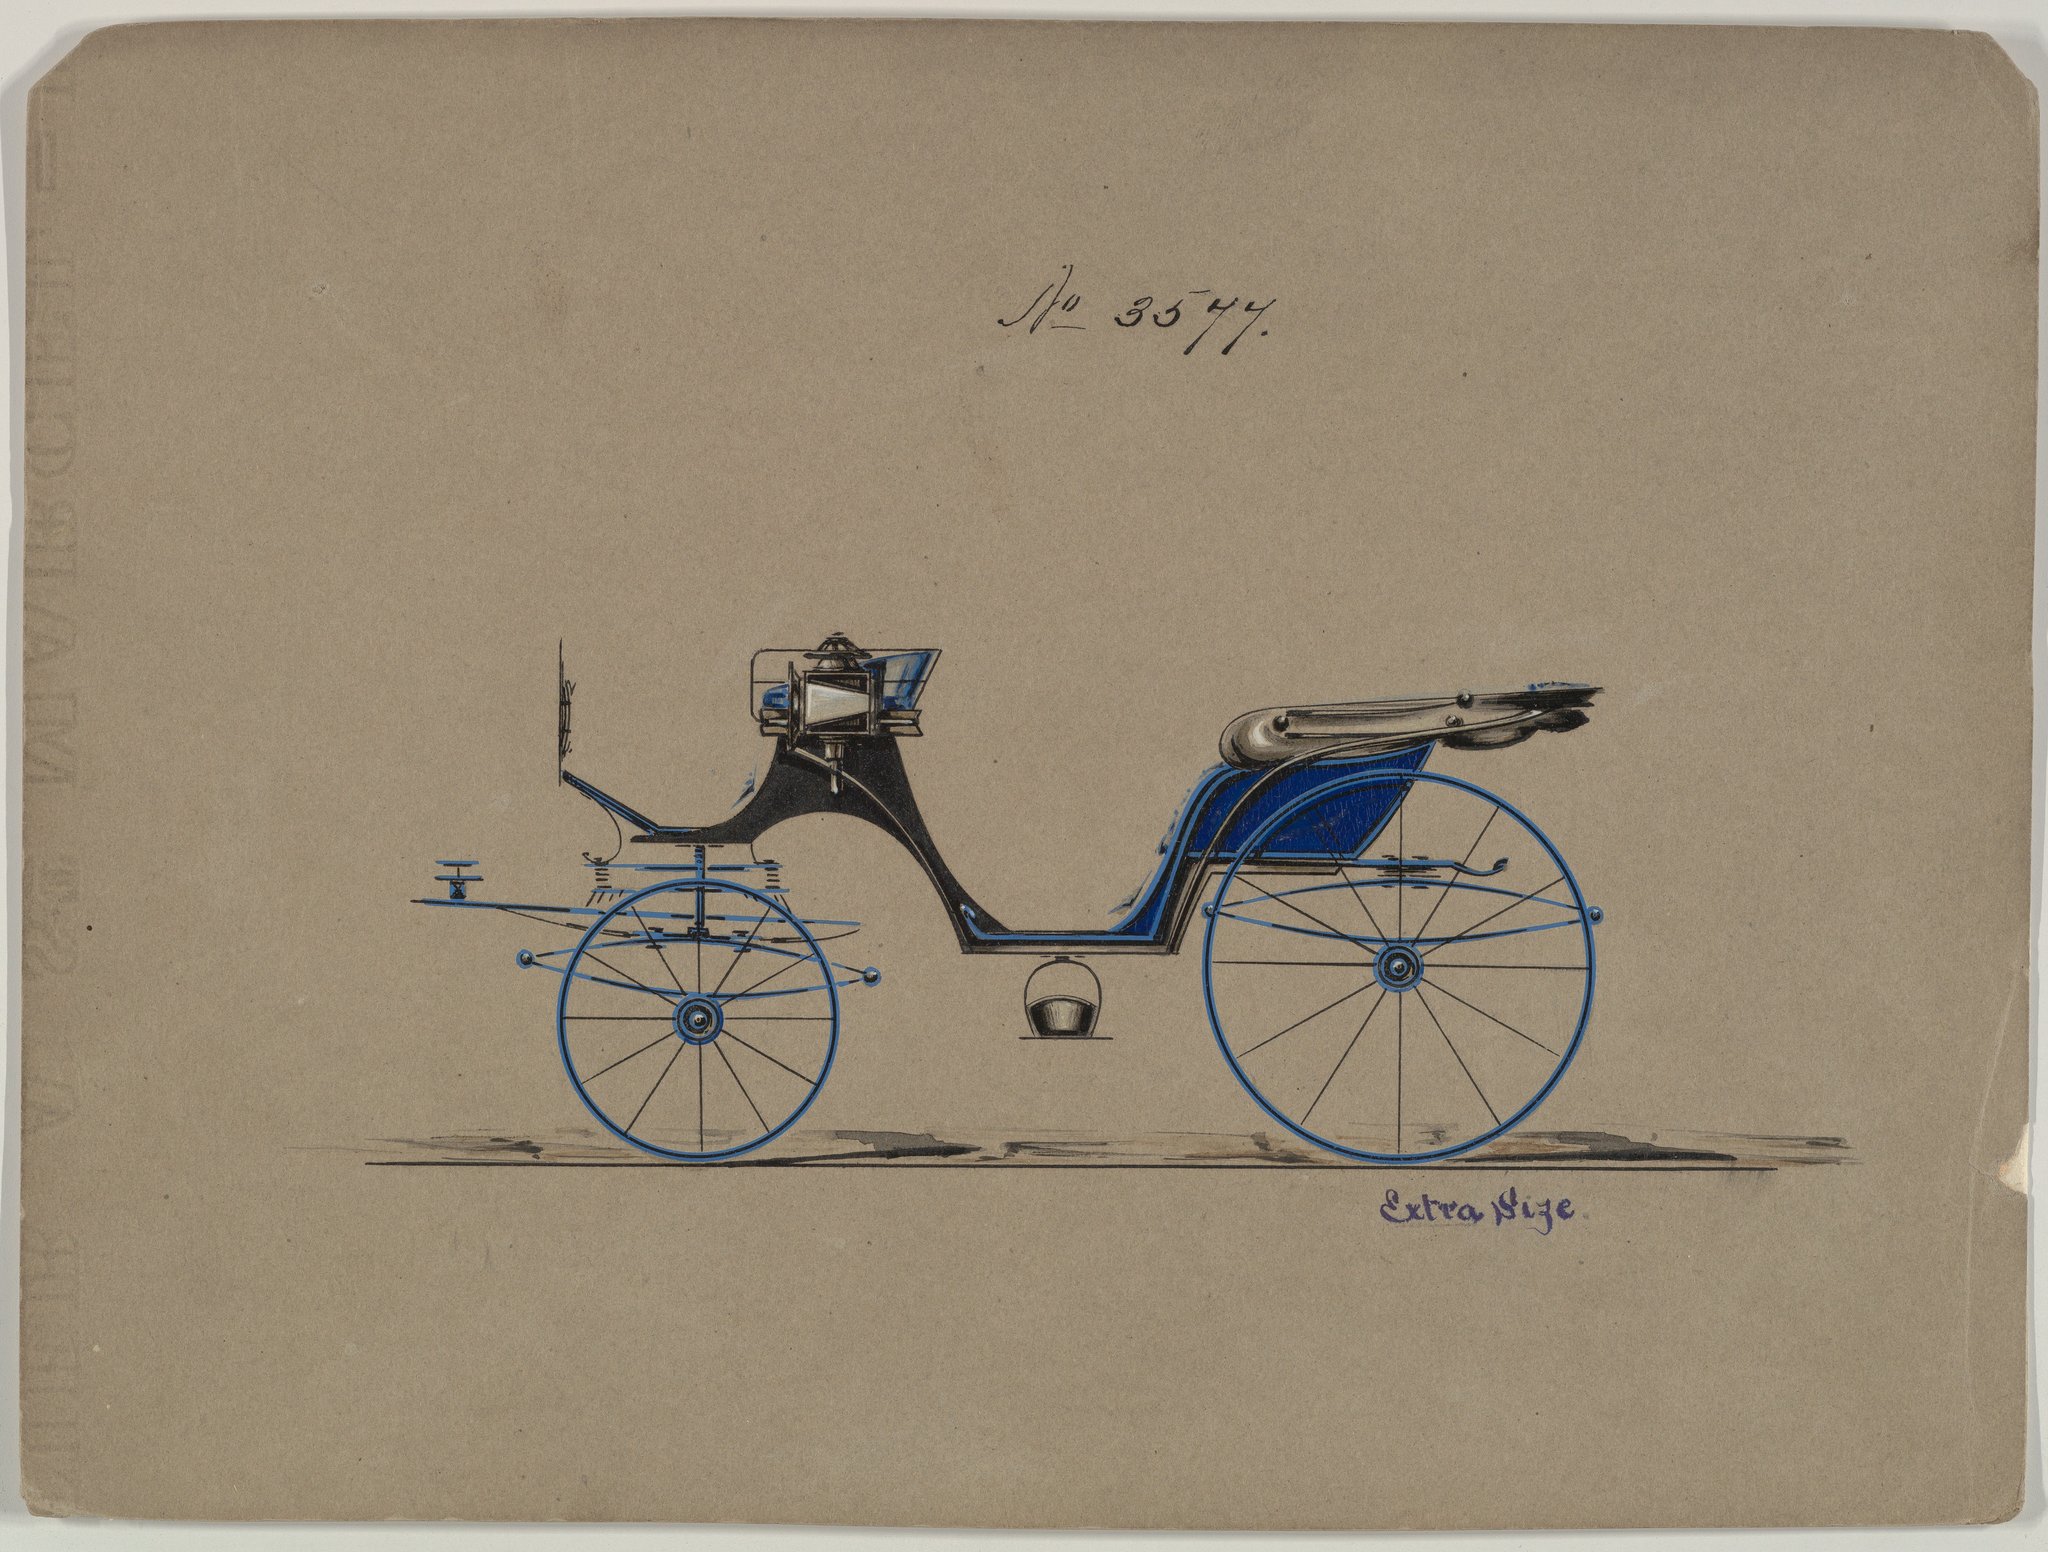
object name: drawing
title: Design for Cabriolet or Victoria, no. 3577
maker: brewster & co.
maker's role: manufacturer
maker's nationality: american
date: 1880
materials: gouache, gum arabic, ink, watercolor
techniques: pen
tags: carriages